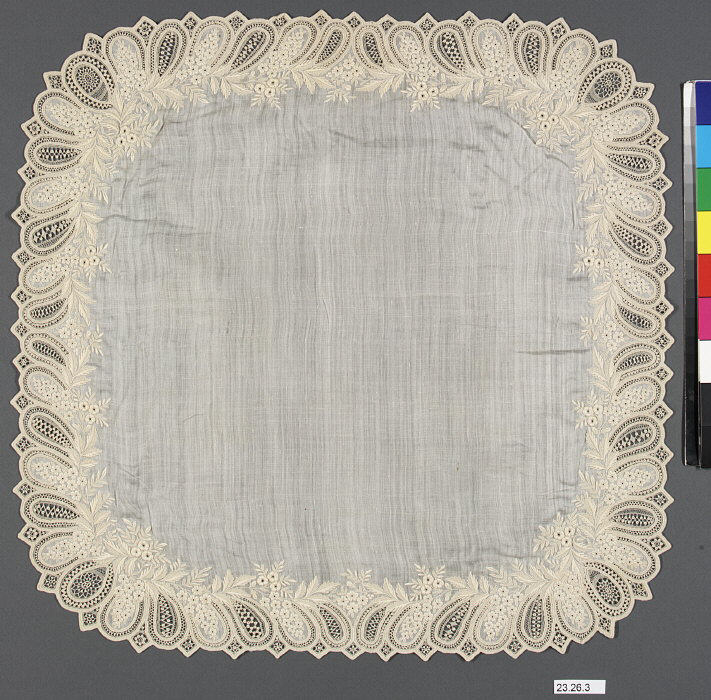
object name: handkerchief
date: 1801-1900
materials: silk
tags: flowers